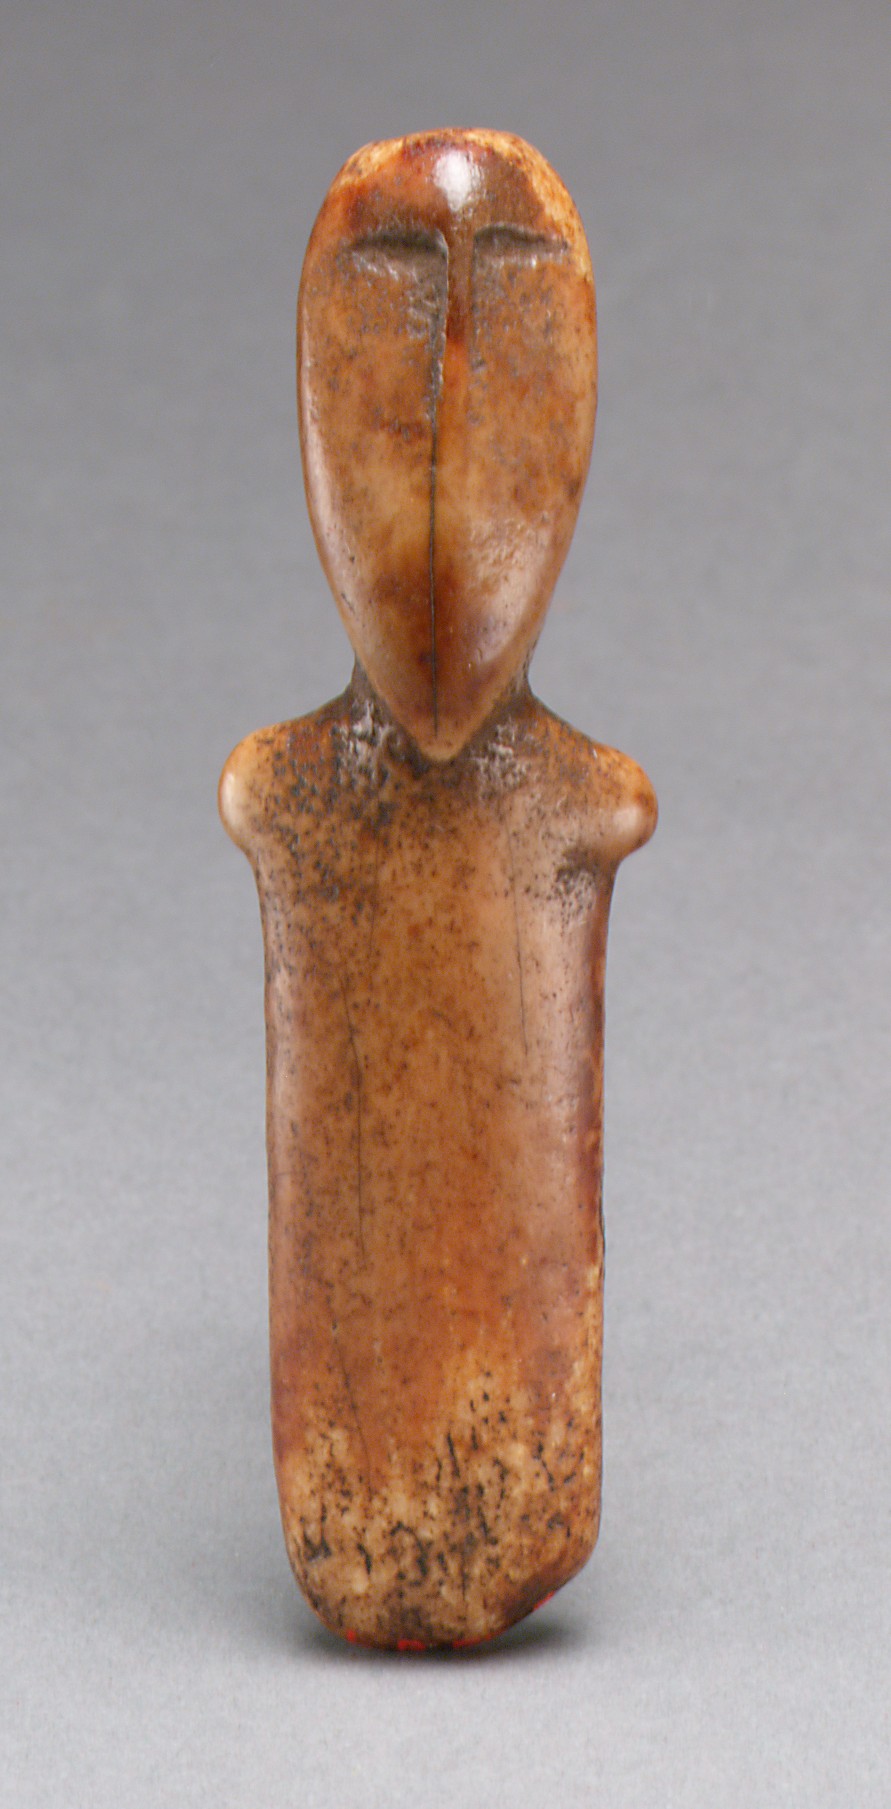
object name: figure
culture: old bering sea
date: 150 BCE-100 CE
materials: ivory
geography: united states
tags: human figures